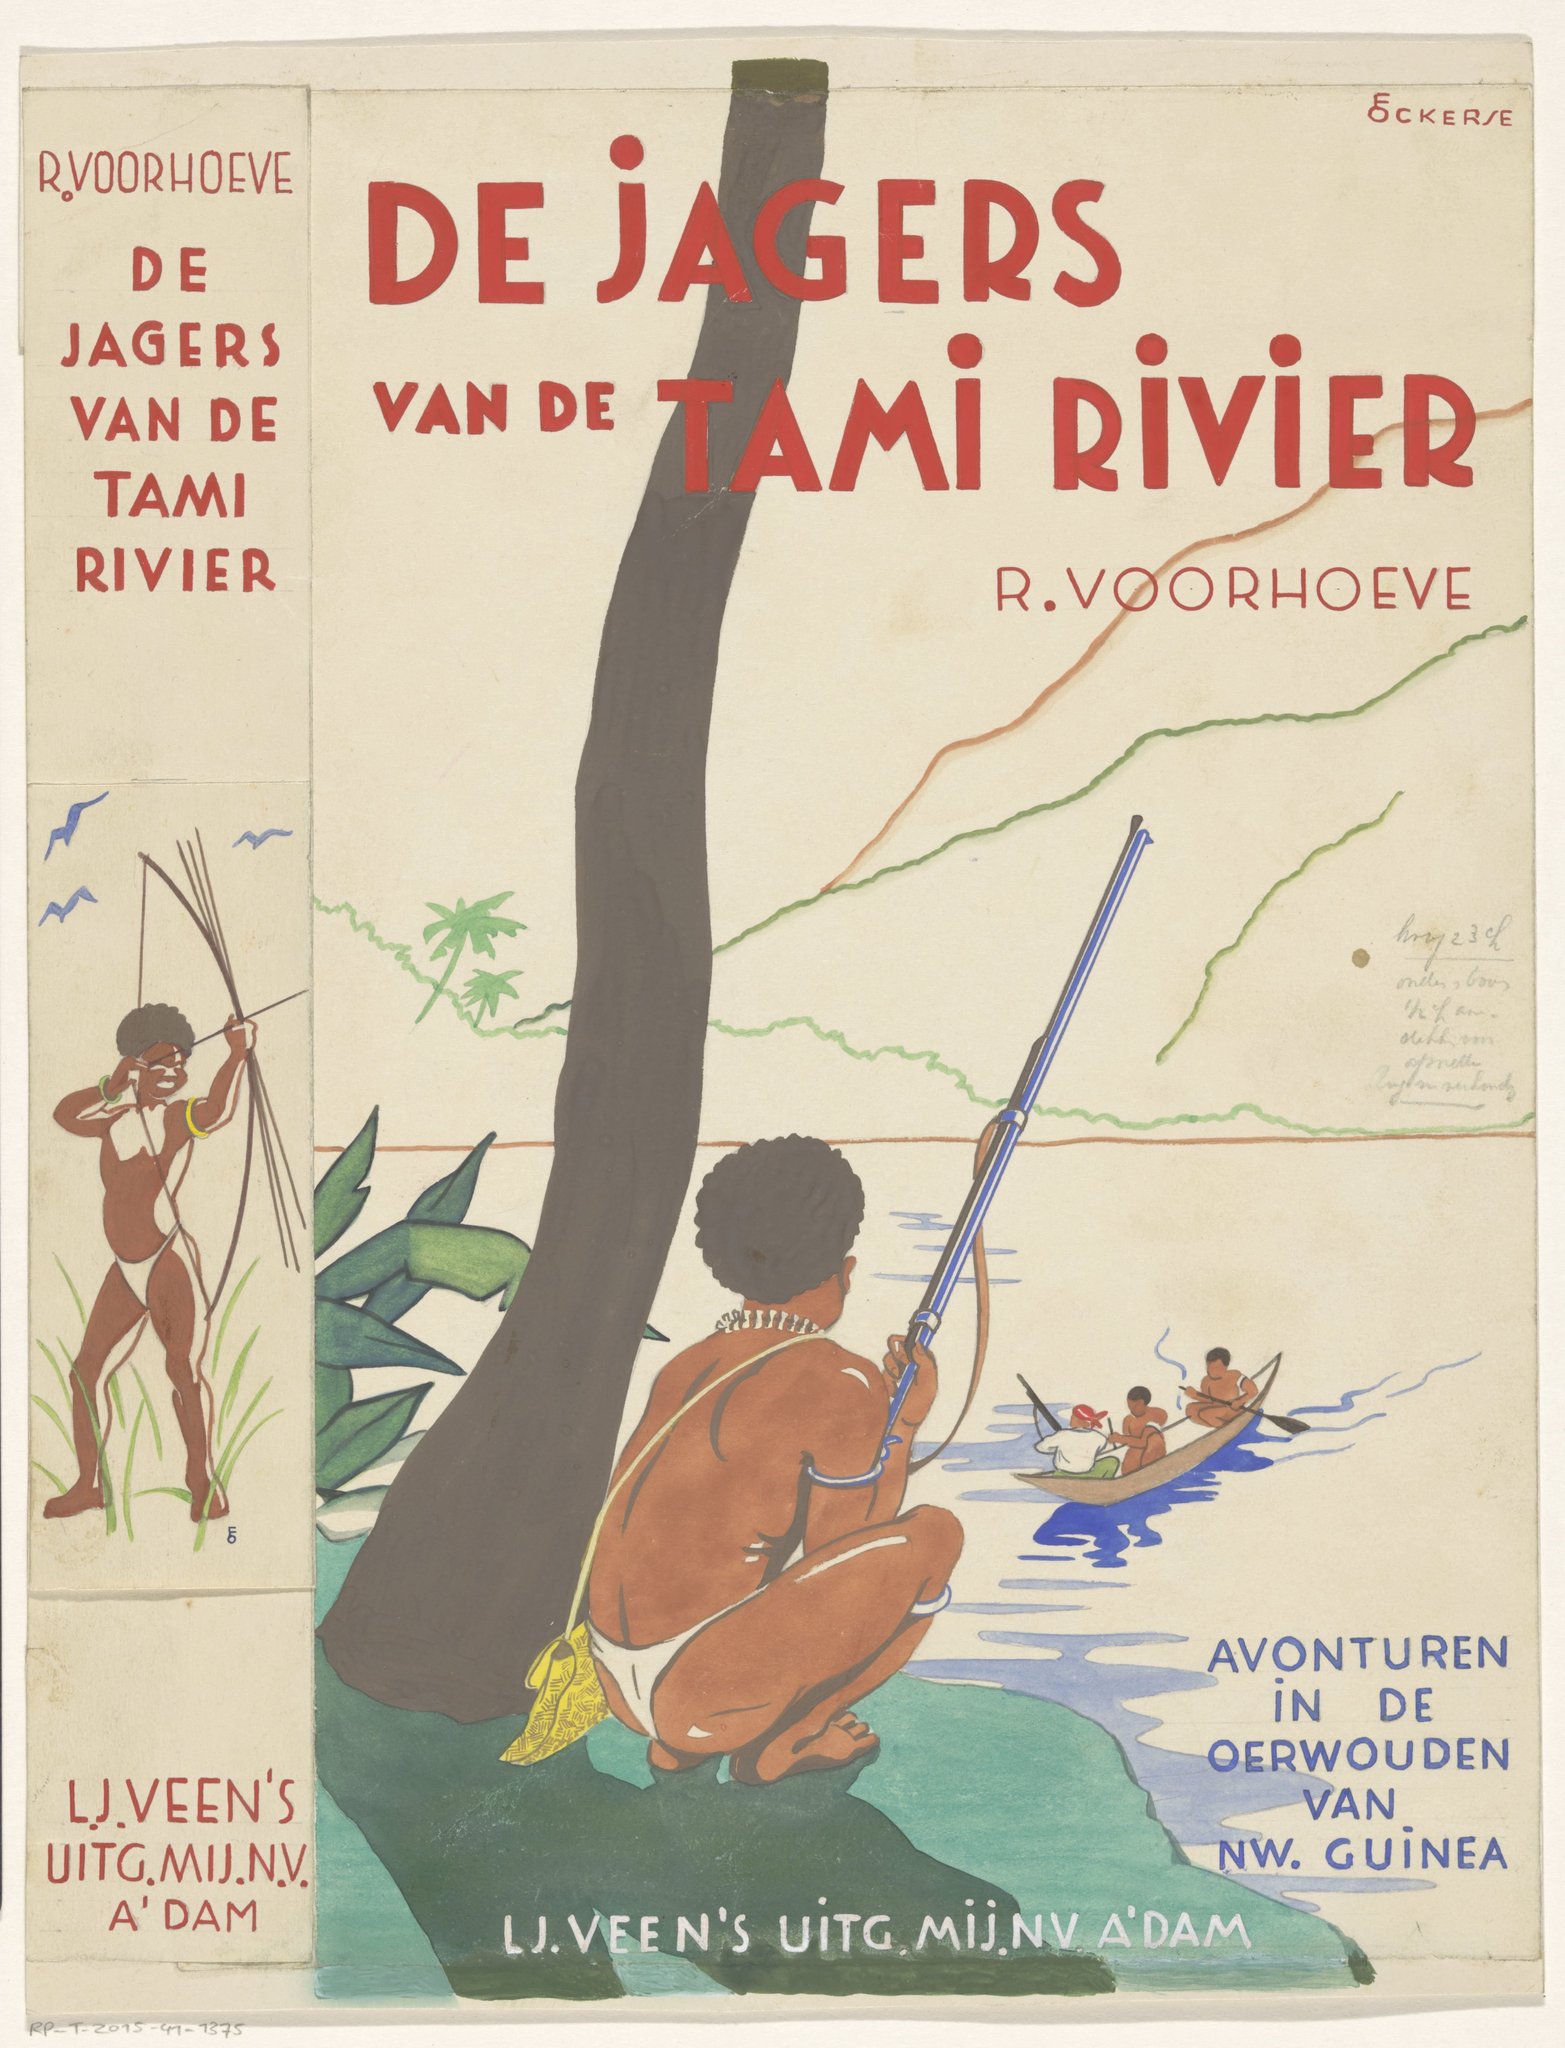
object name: study for binding design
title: Bandontwerp voor: Rudolf Voorhoeve, De jagers van de Tamirivier: Avonturen in de oerwouden van Nieuw-Guinea, 1936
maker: f. ockerse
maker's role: draughtsman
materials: paint, paper, pencil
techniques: brush, pen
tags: archer's weapons: bow and arrow, hunter, landscapes in tropical and sub-tropical regions, rowing-boat, canoe, etc.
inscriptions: collector's mark: Lugt 2228, :, signature: ‘F/ O/ F/ OCKERSE’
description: Een Nieuw-Guineese jager in een lendendoek zit op zijn hurken aan een waterkant met een wapen in zijn hand. Hij kijkt naar een sloep op het water waar drie mannen in zitten, onder wie één man met een geweer. In de achtergrond bergen. Op de boekrug een jager die een pijl op zijn boog spant.